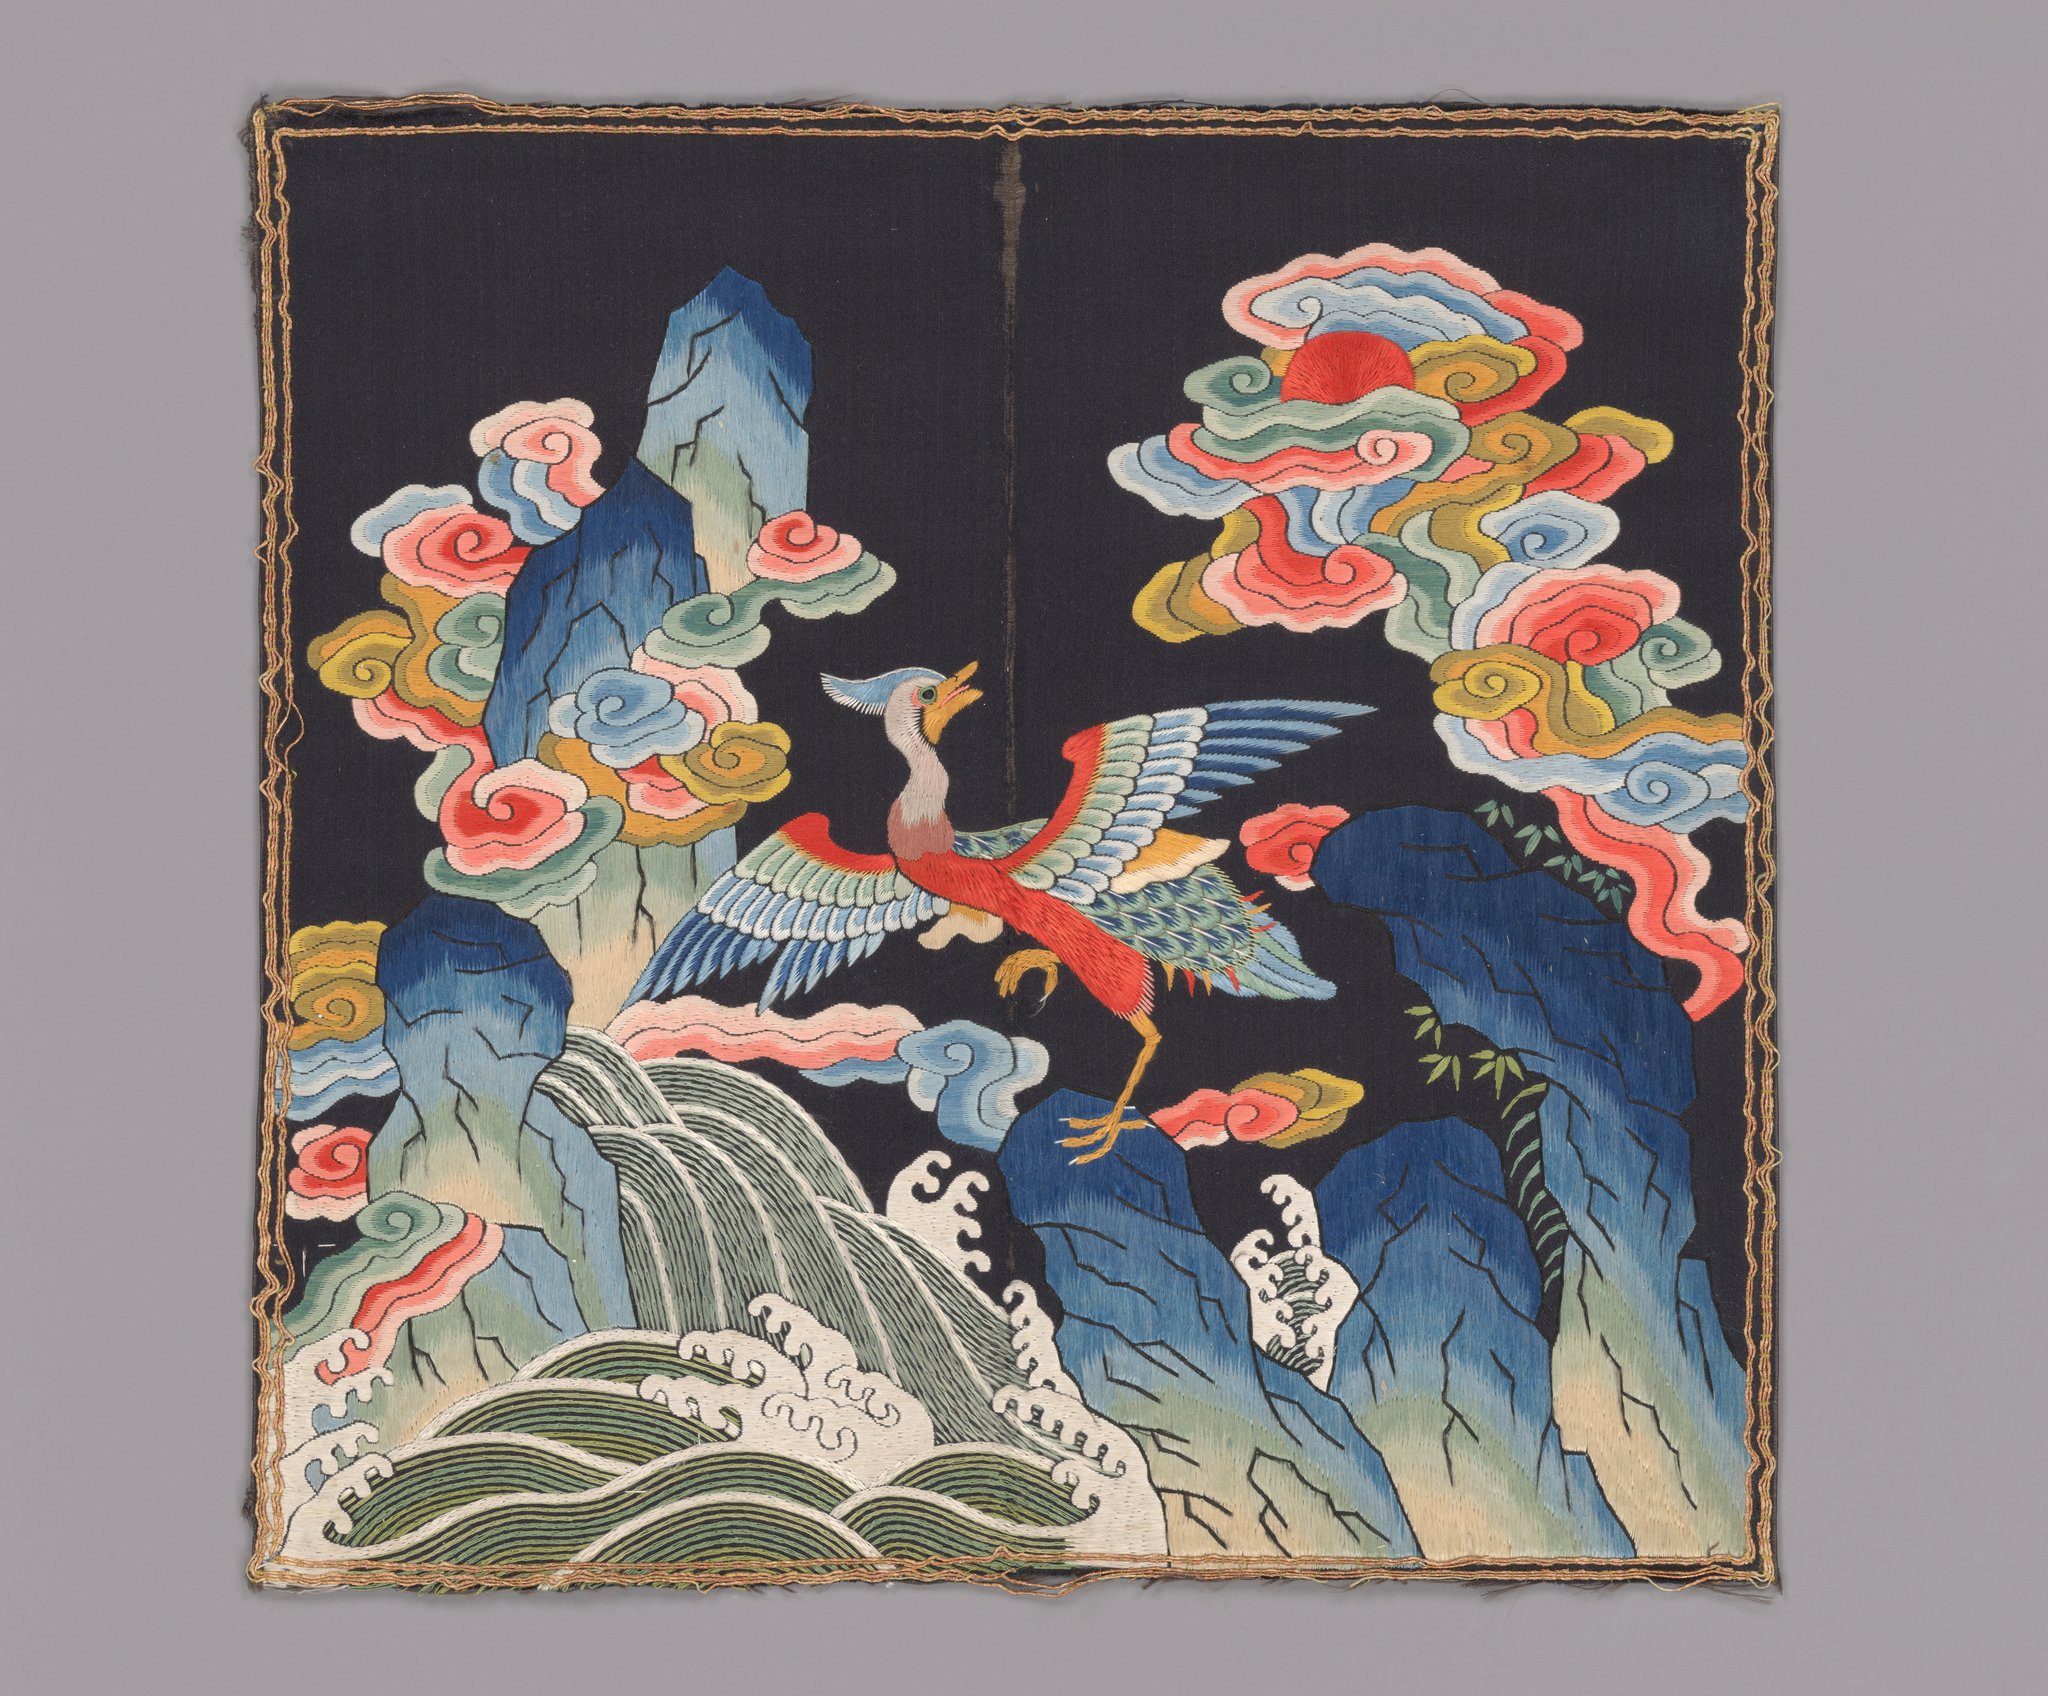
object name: rank badge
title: Rank Badge with Mandarin Duck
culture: chinese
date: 1701-1733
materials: metal thread, silk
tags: ducks